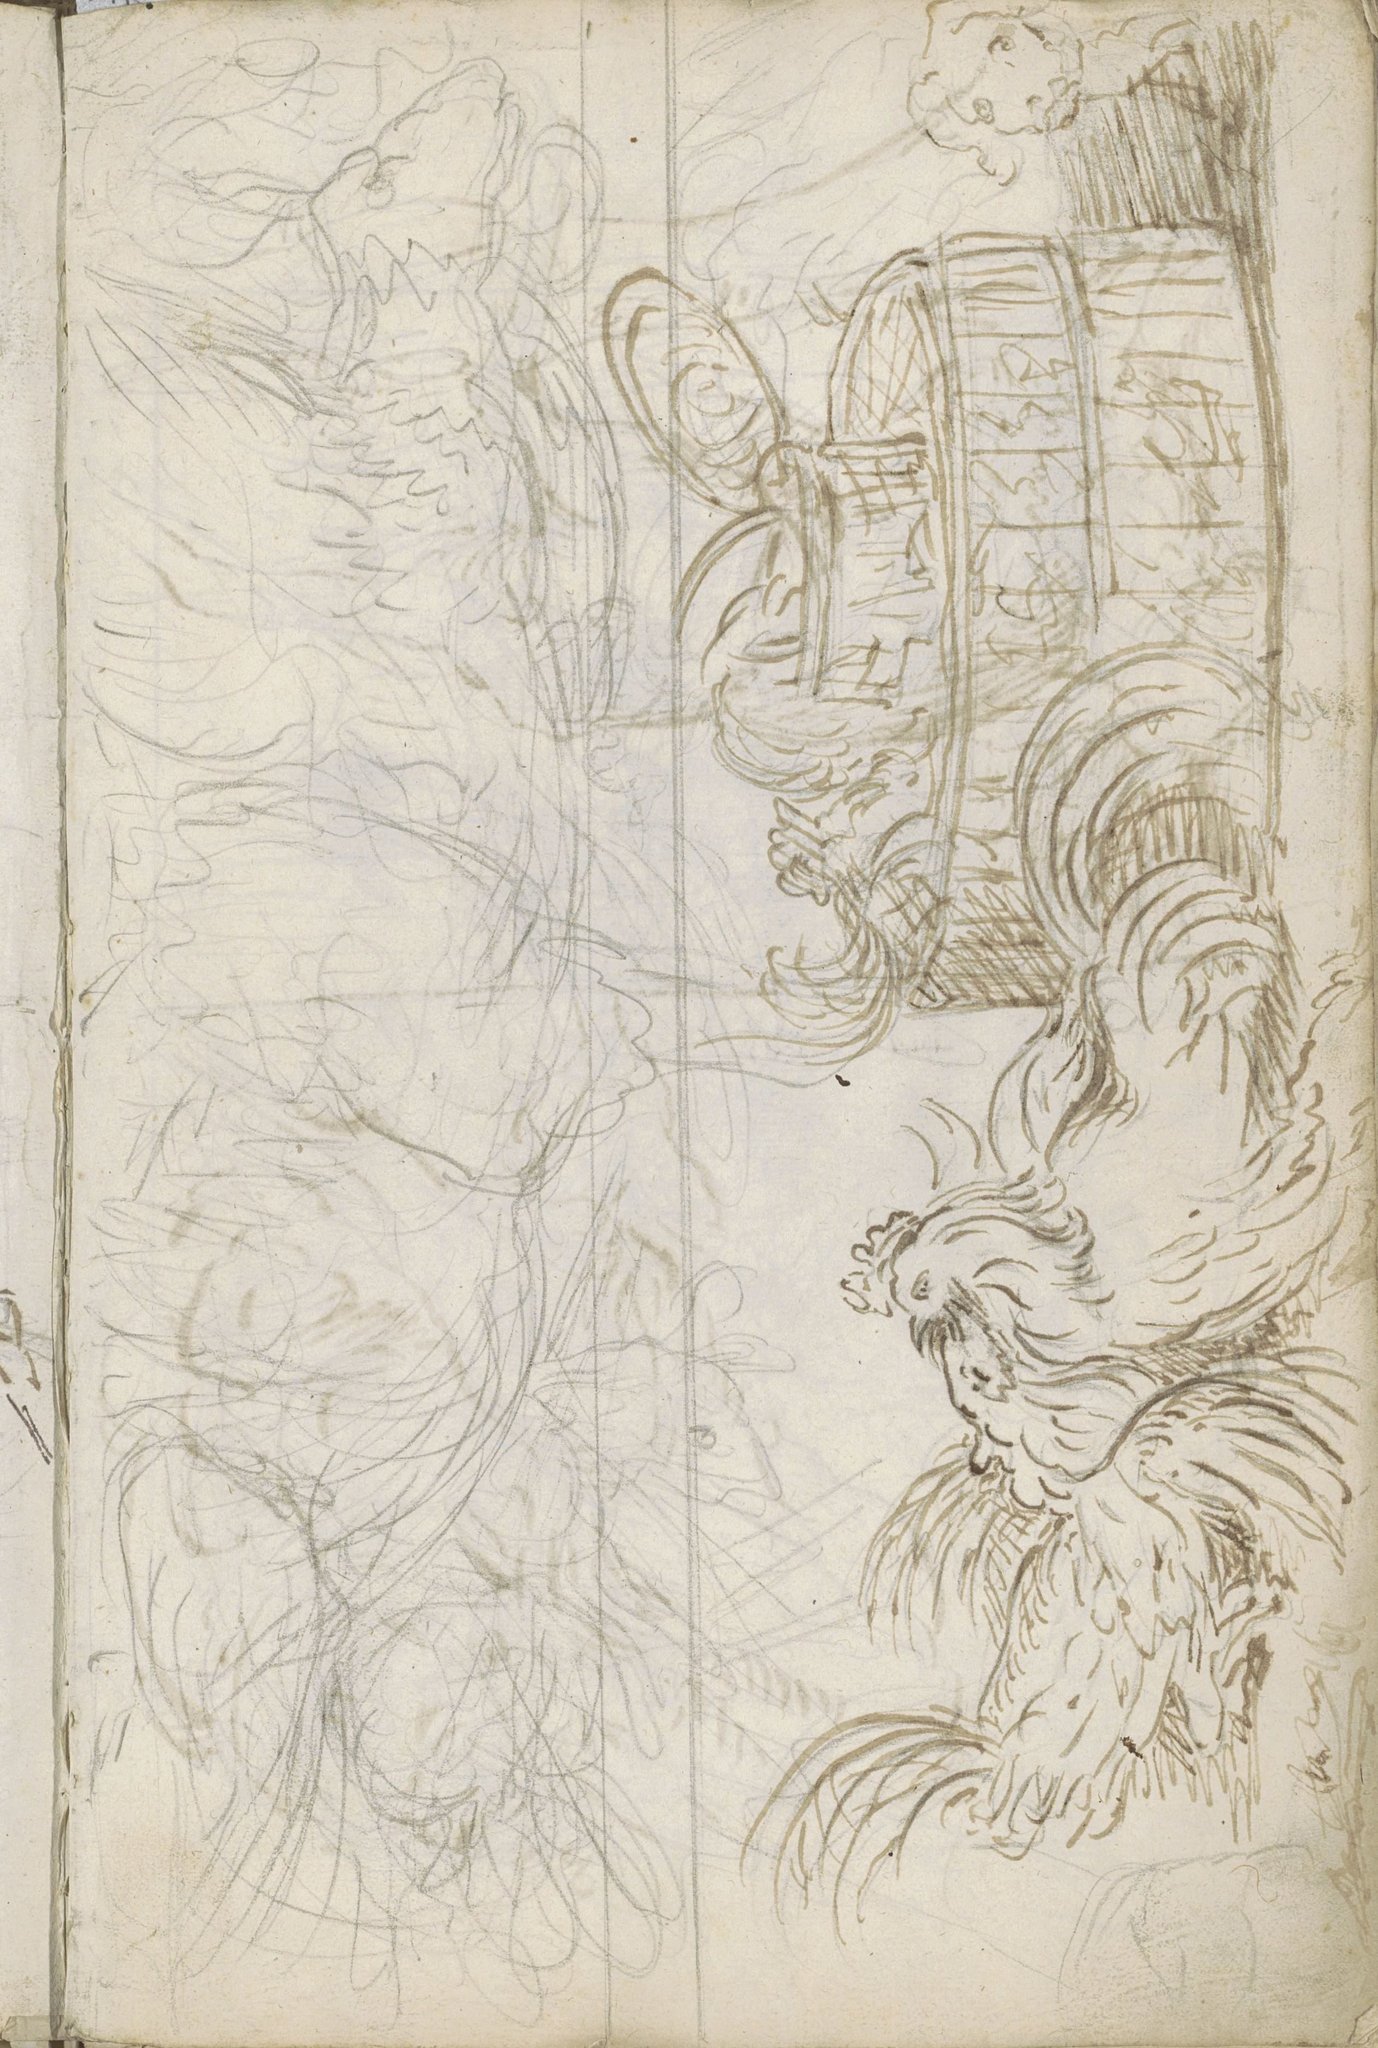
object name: sketchbook leaf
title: Kippen en een hond bij een mand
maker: paul de vos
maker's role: draughtsman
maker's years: 1595-1678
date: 1605-1678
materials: ink, paper, pencil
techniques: brush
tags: fowl (cock, hen, chicken, etc.)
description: Blad 2 recto uit een schetsboek met 15 bladen.